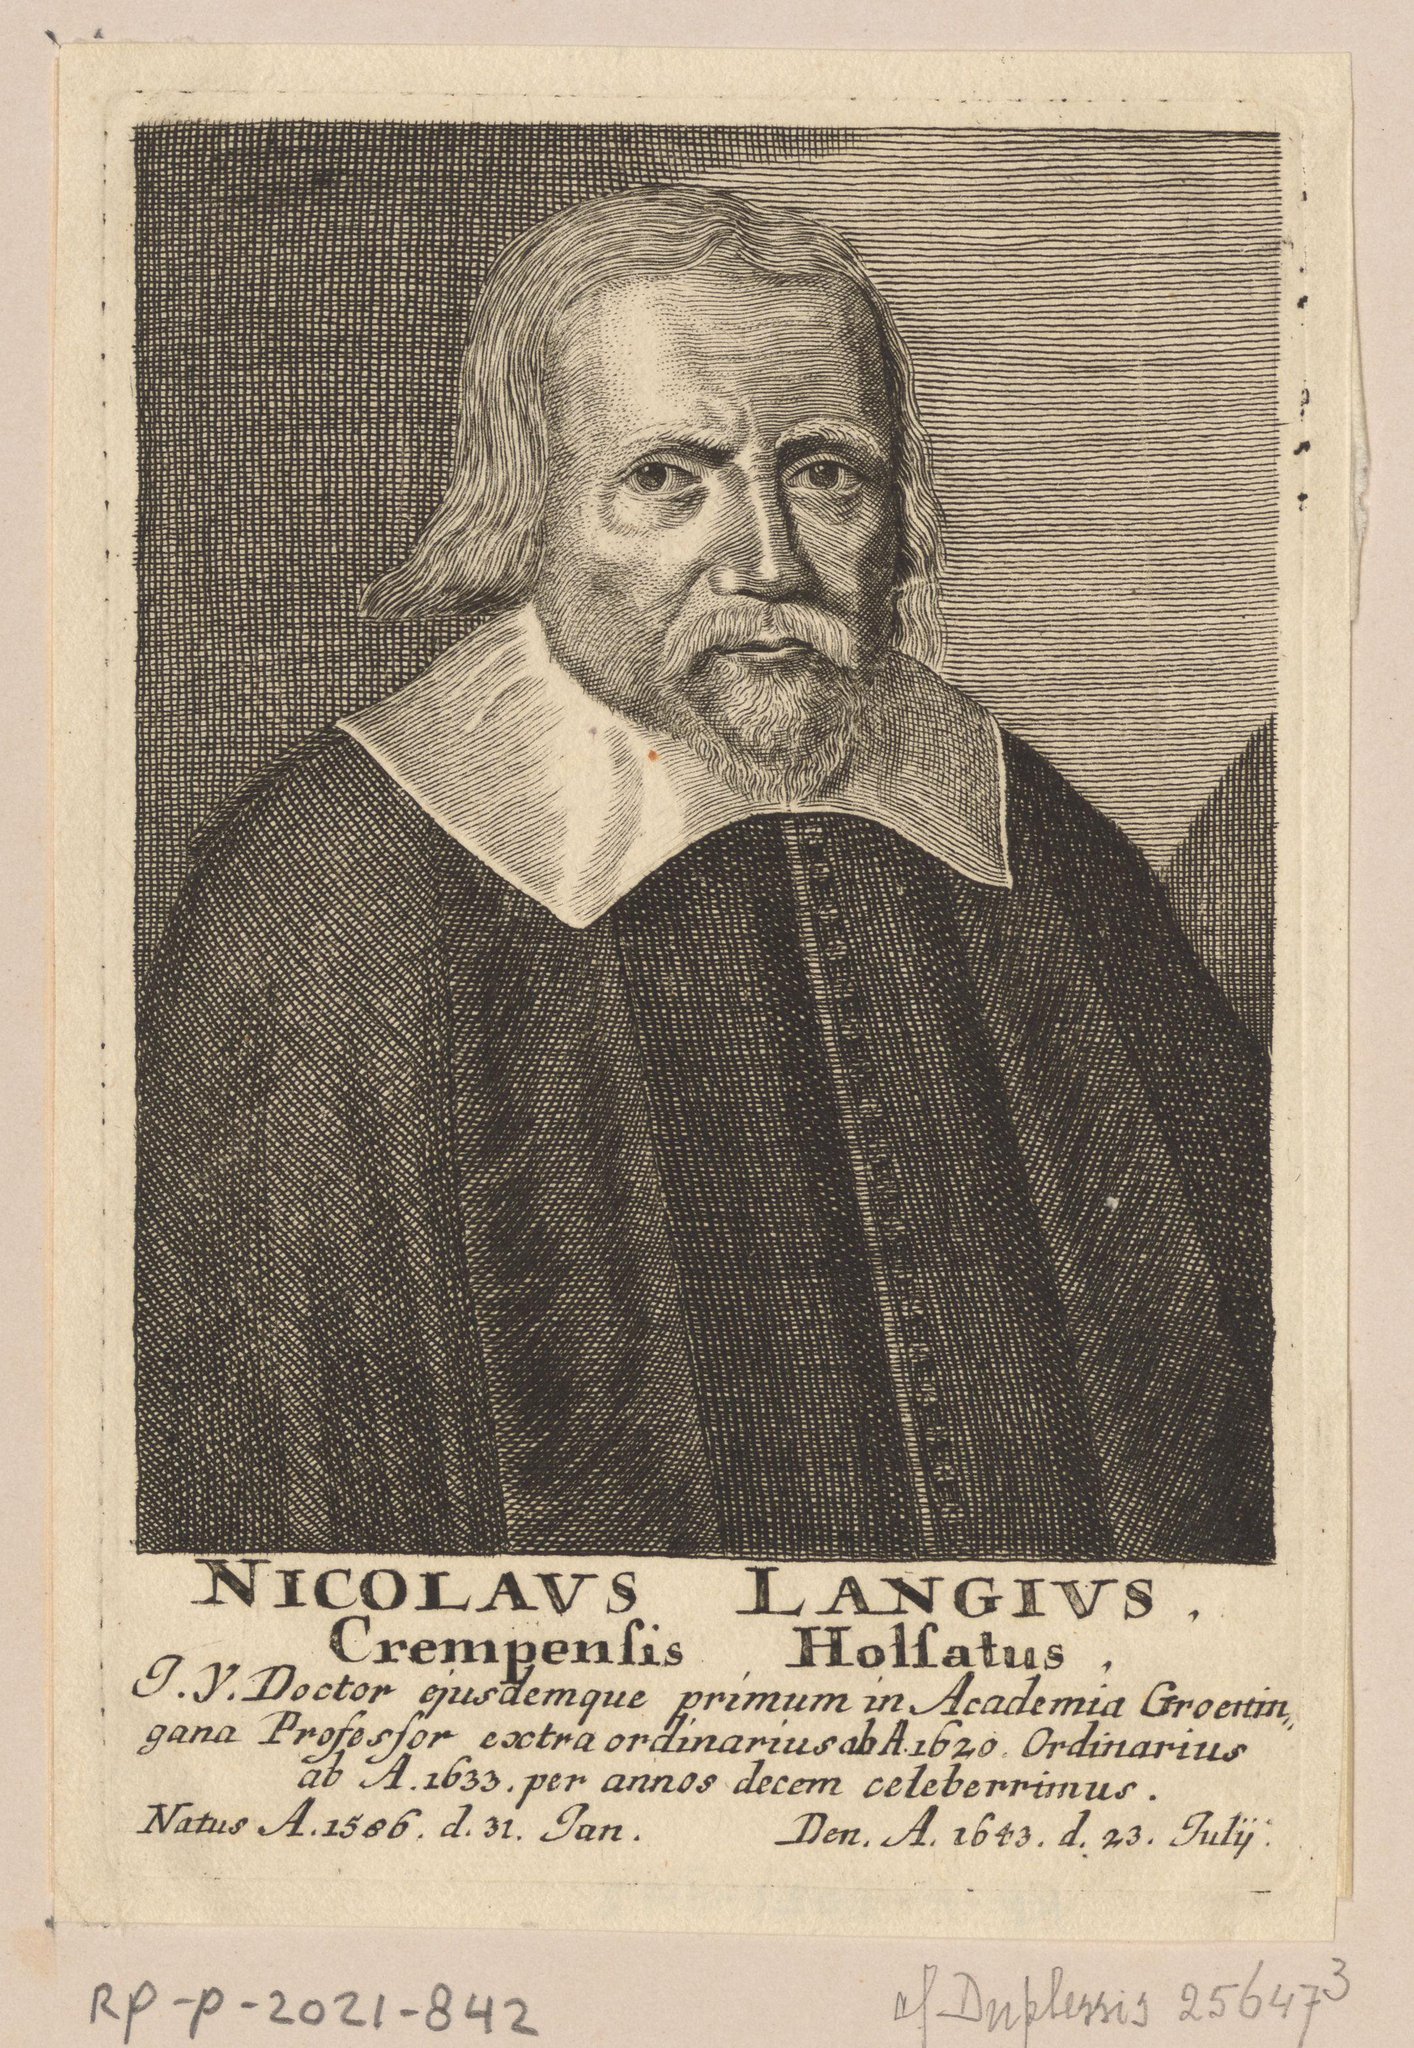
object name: book illustration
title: Portret van Nicolaas Langius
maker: Anonymous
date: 1725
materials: paper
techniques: engraving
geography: germany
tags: historical persons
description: Prent waarschijnlijk uit: Roth-Scholtz, Friedrich. Icones virorum omnium ordinum eruditione omnique item genere (...). Neurenberg: erven Johann Daniel Tauber, 1725.